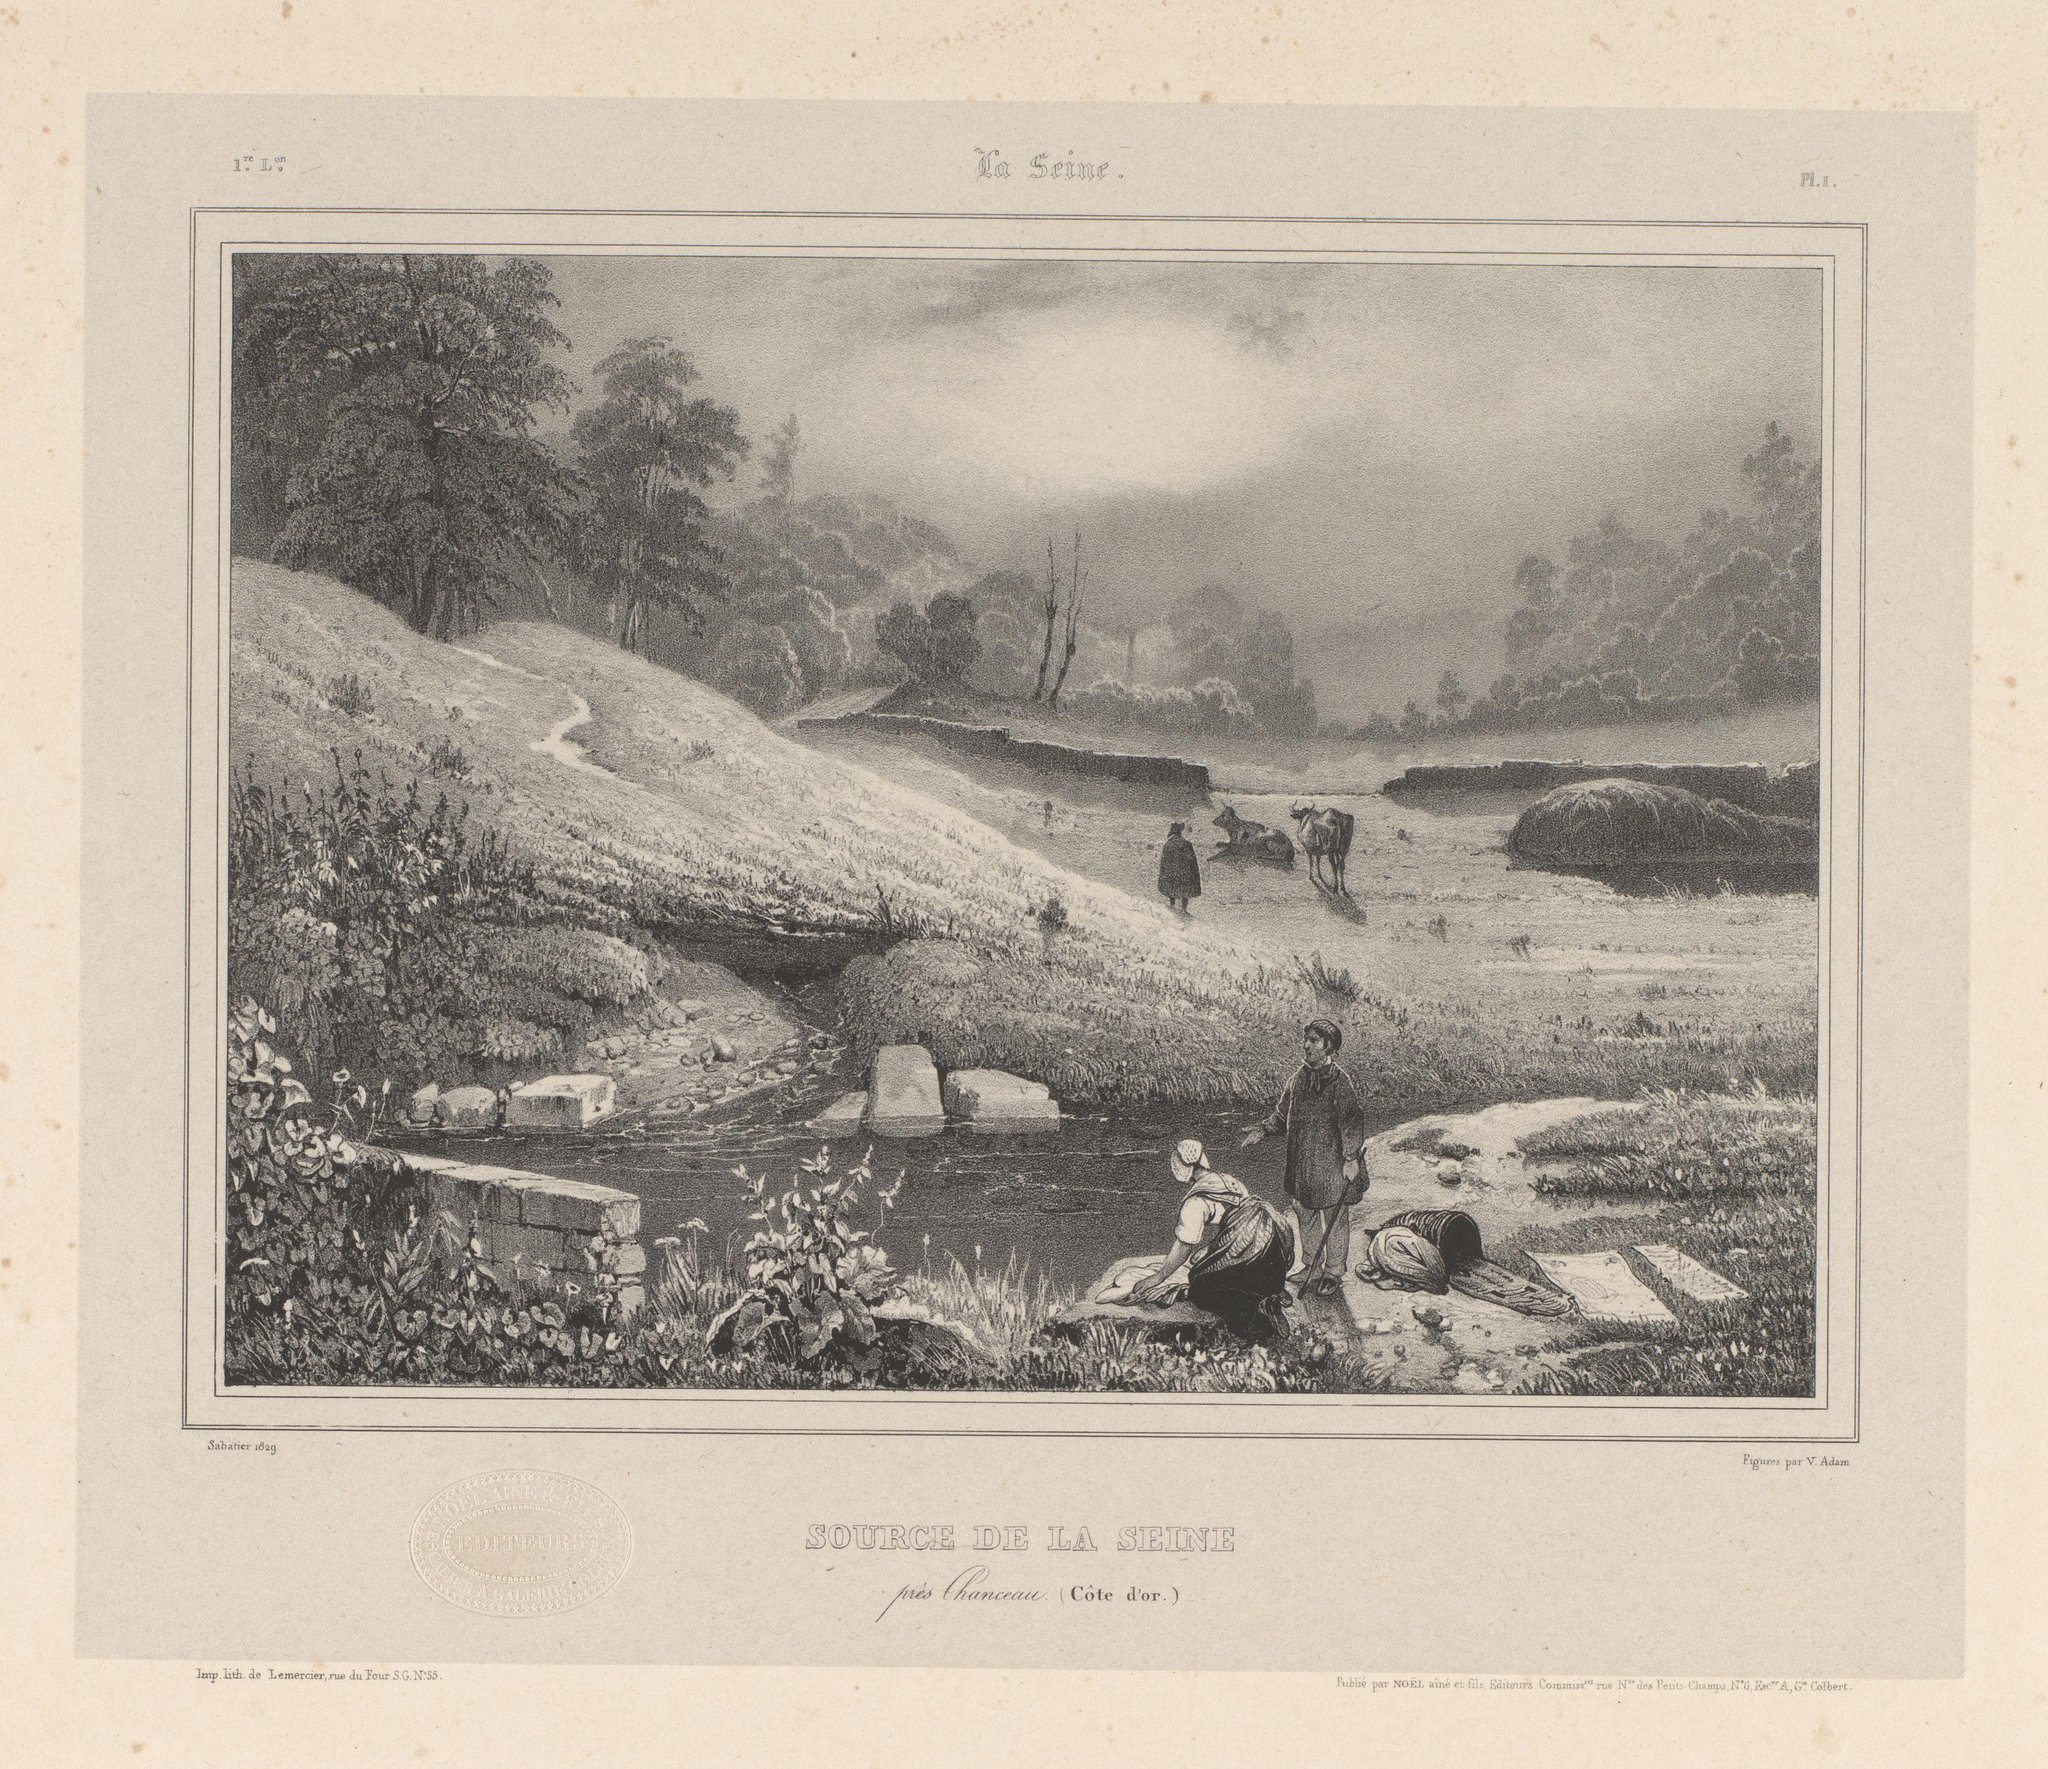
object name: print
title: La Seine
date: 1829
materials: paper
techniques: lithograph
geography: paris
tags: cow, river, landscapes - hh - ideal landscapes (+ landscape with figures, staffage)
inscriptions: collector's mark: Lugt 2228, check stamp: Lugt 4944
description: Linksboven staat: 1er. Lon. (= première livraison).